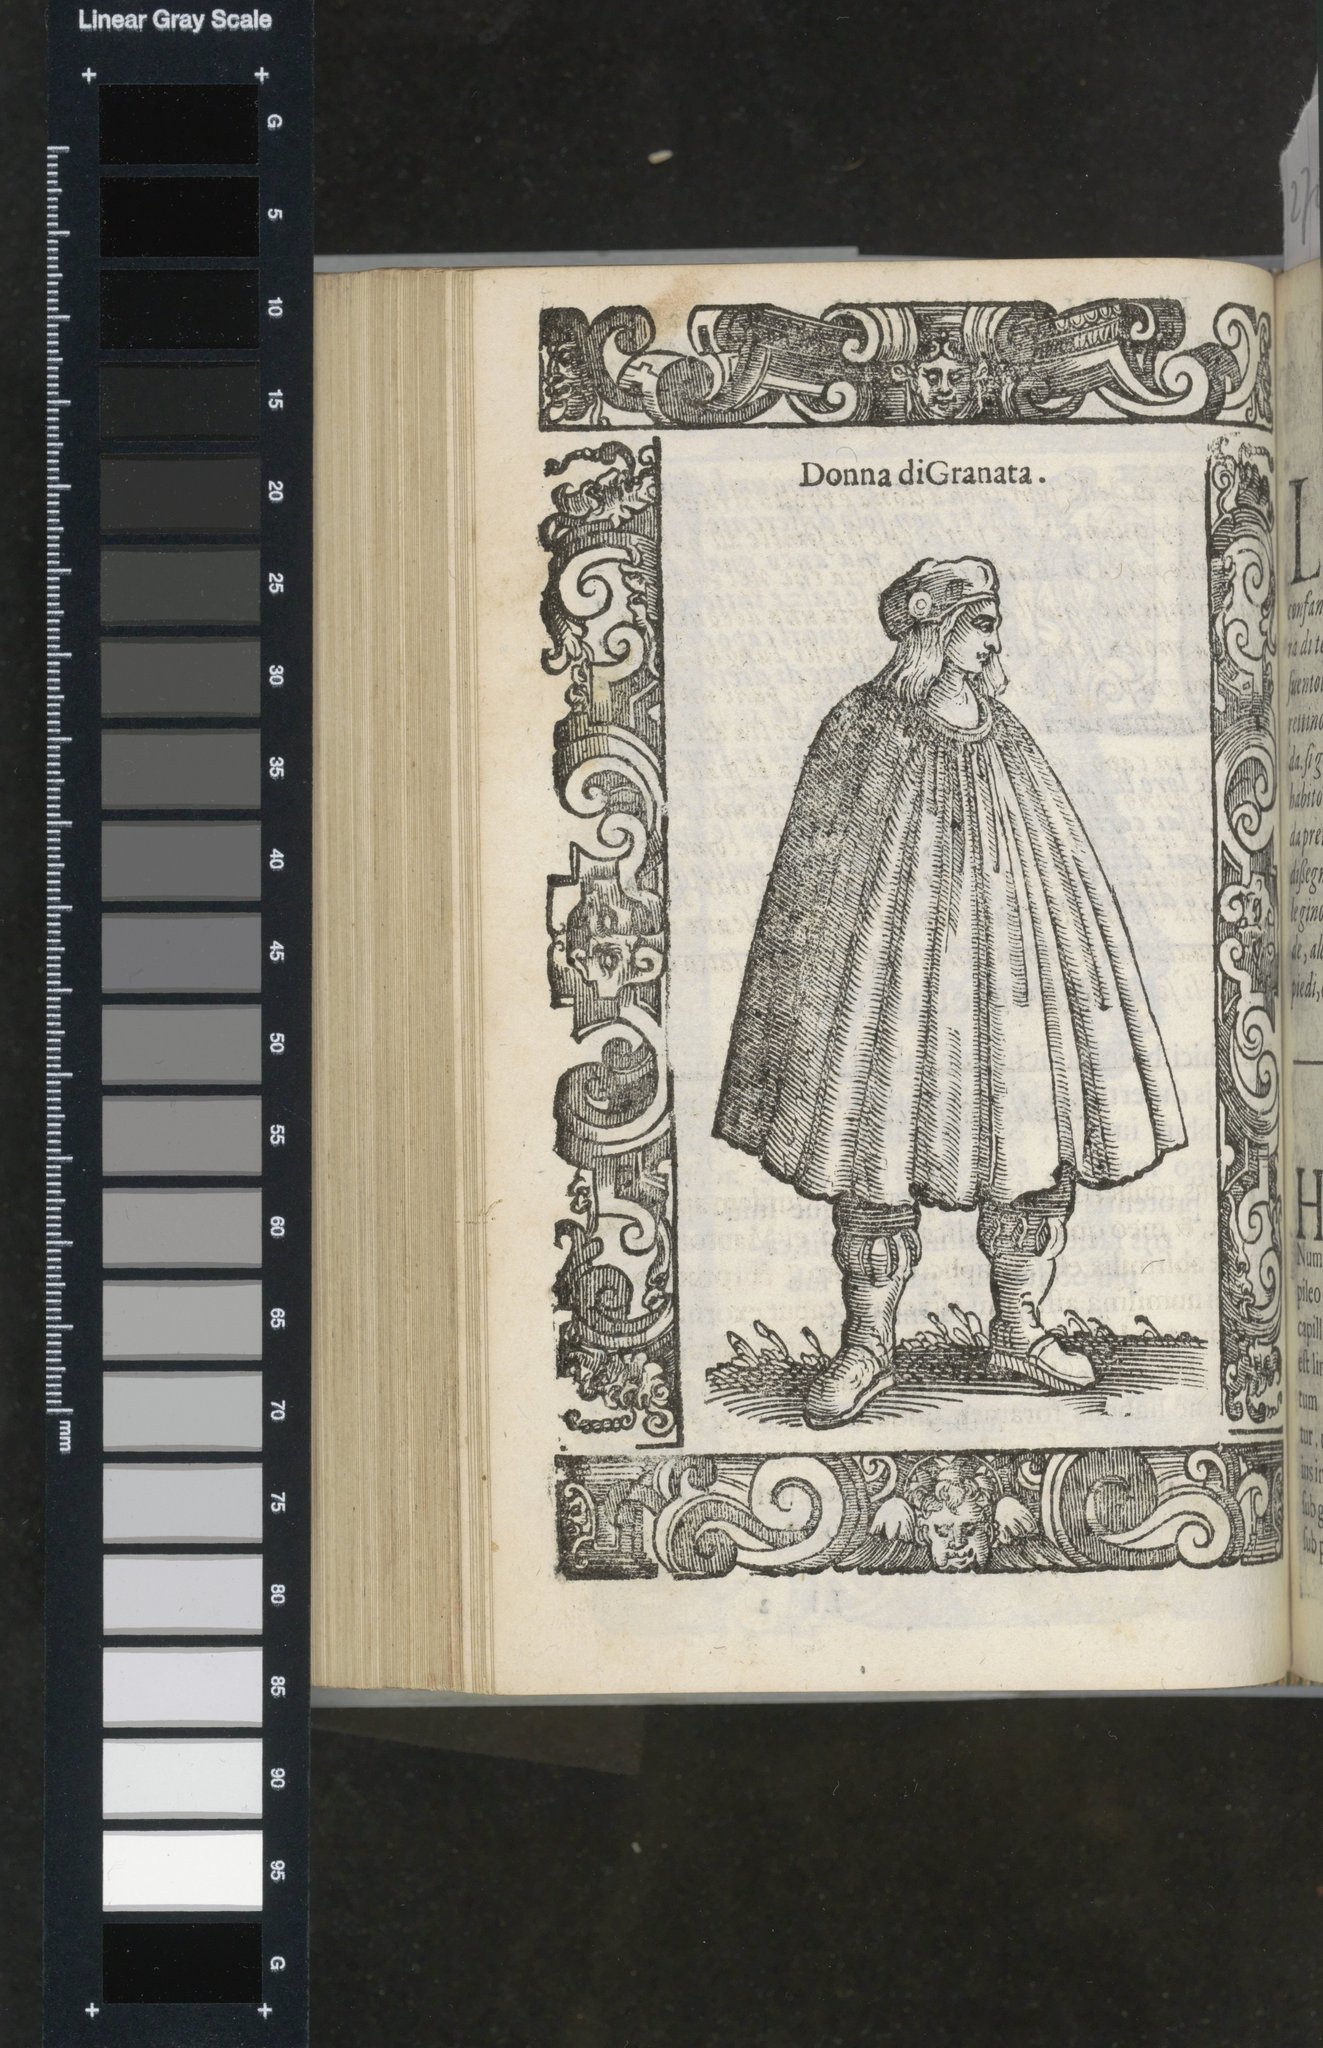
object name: costume print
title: Donna di Granata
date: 1598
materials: paper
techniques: woodcut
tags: boots (+ women's clothes), cape (+ women's clothes), head-gear: cap (+ women's clothes)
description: Jonge vrouw uit Granada, gekleed in een wijde cape tot op de kuit. Muts met medaillon op het half lange haar. In ornamentrand.